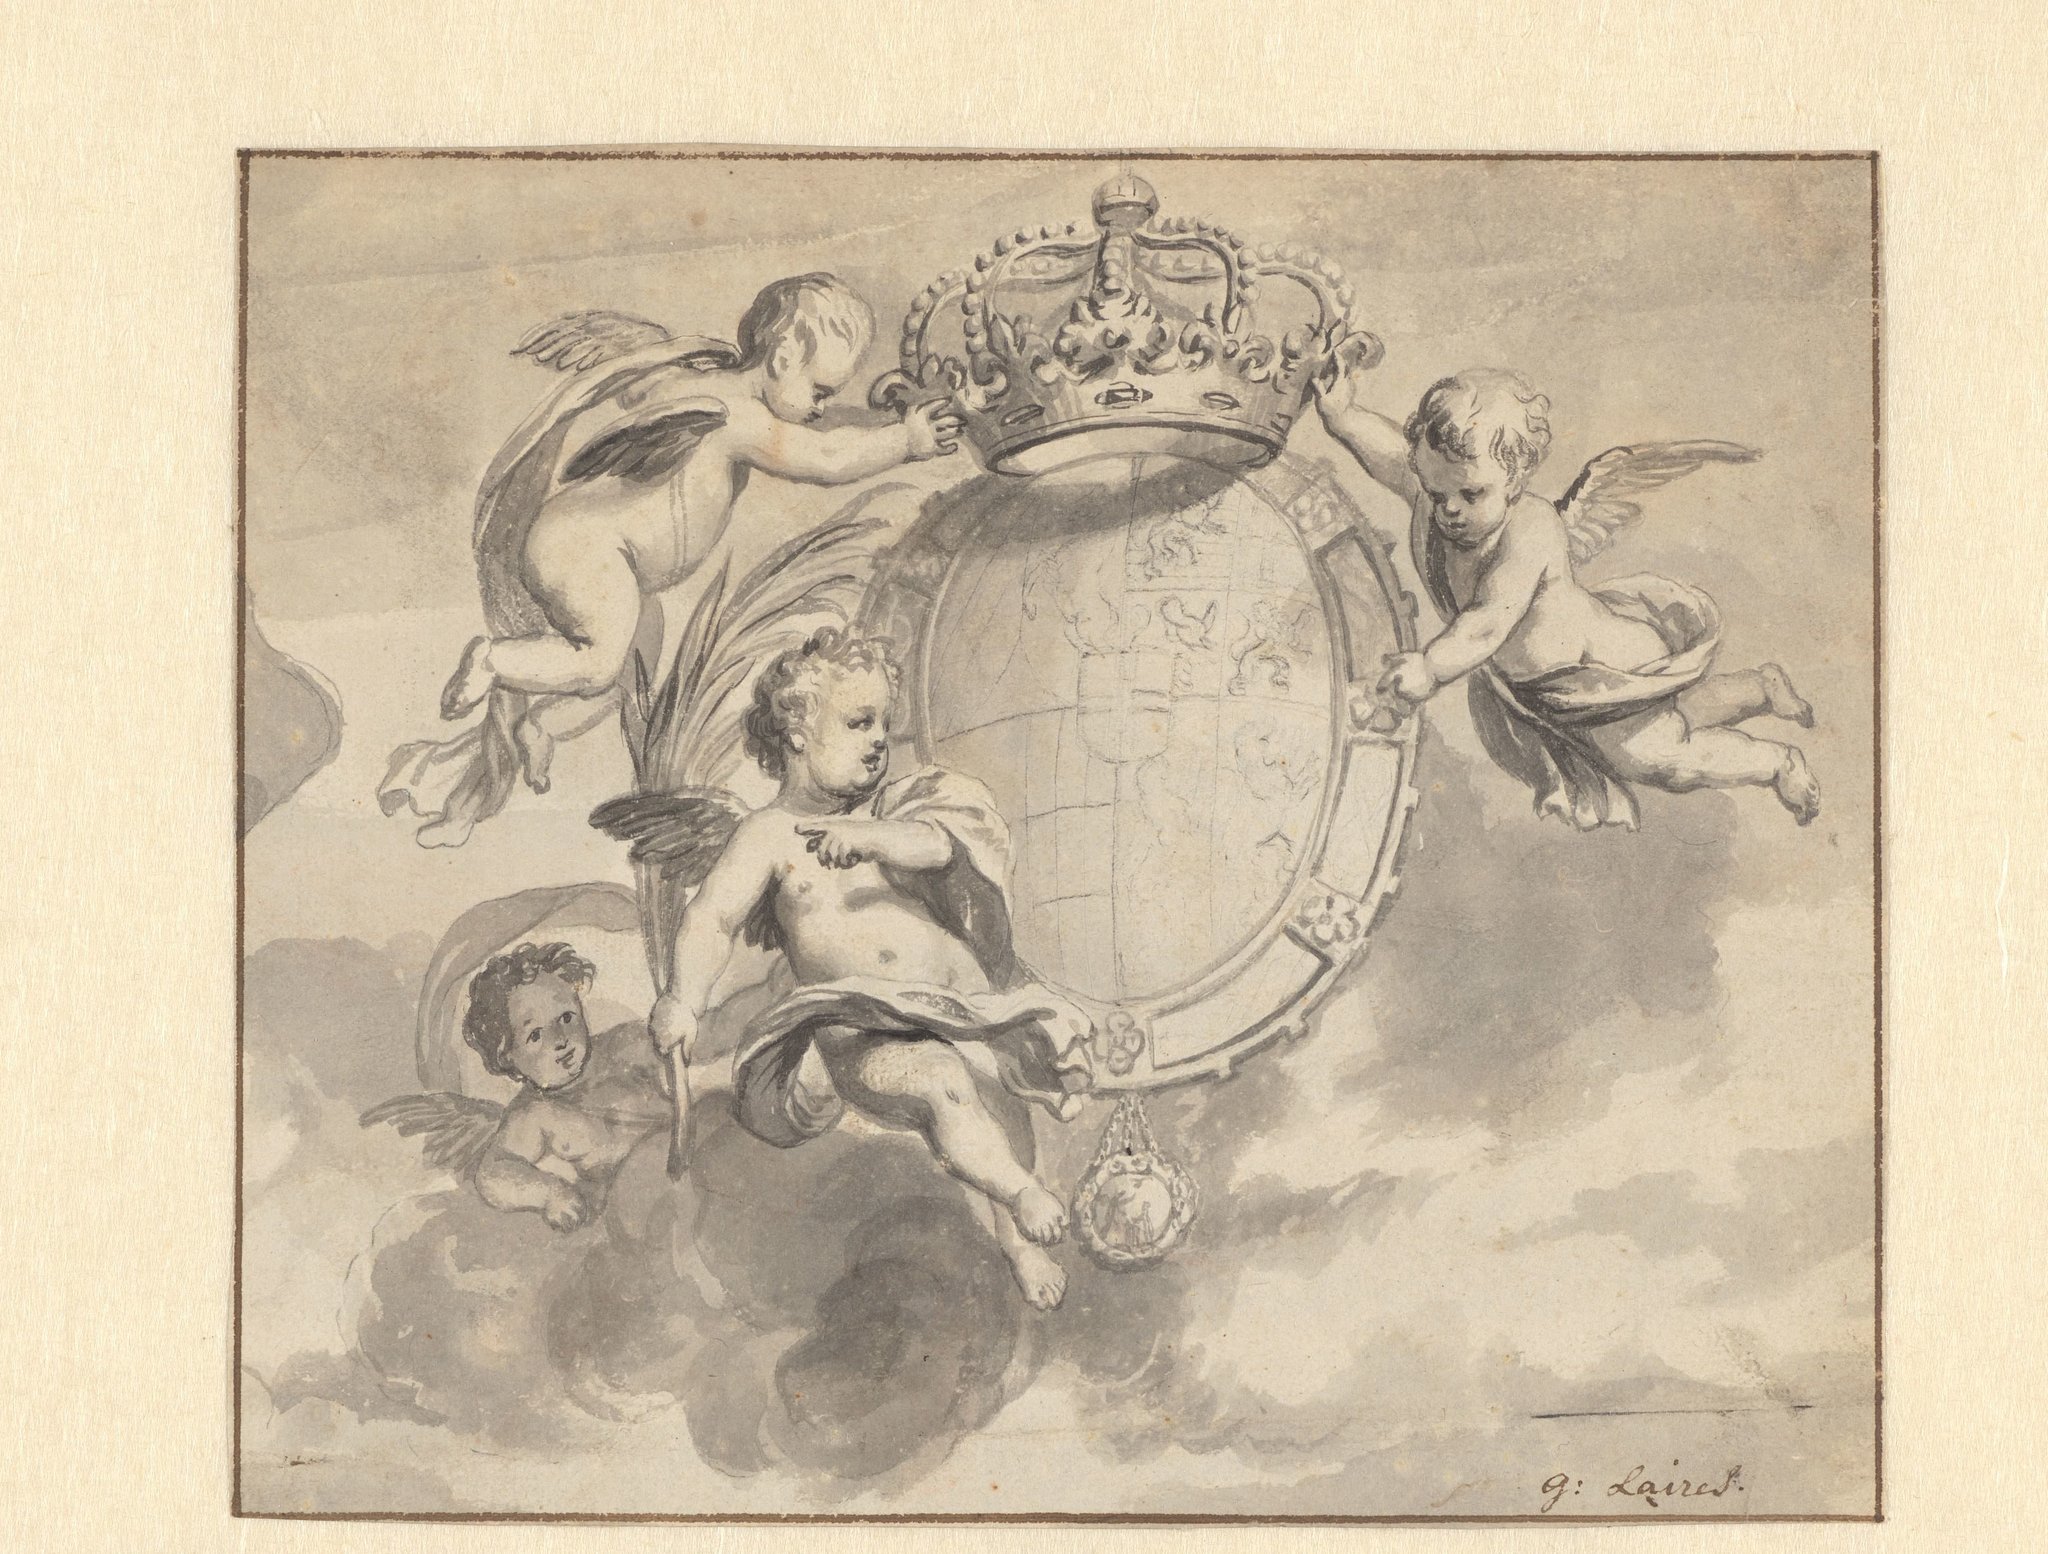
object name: drawing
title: Drie putti met het wapen van het huis van Savoye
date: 1667-1705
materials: chalk, paper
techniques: brush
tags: cupids: 'amores', 'amoretti', 'putti', coat of arms (as symbol of the state, etc.) (+ province; provincial)